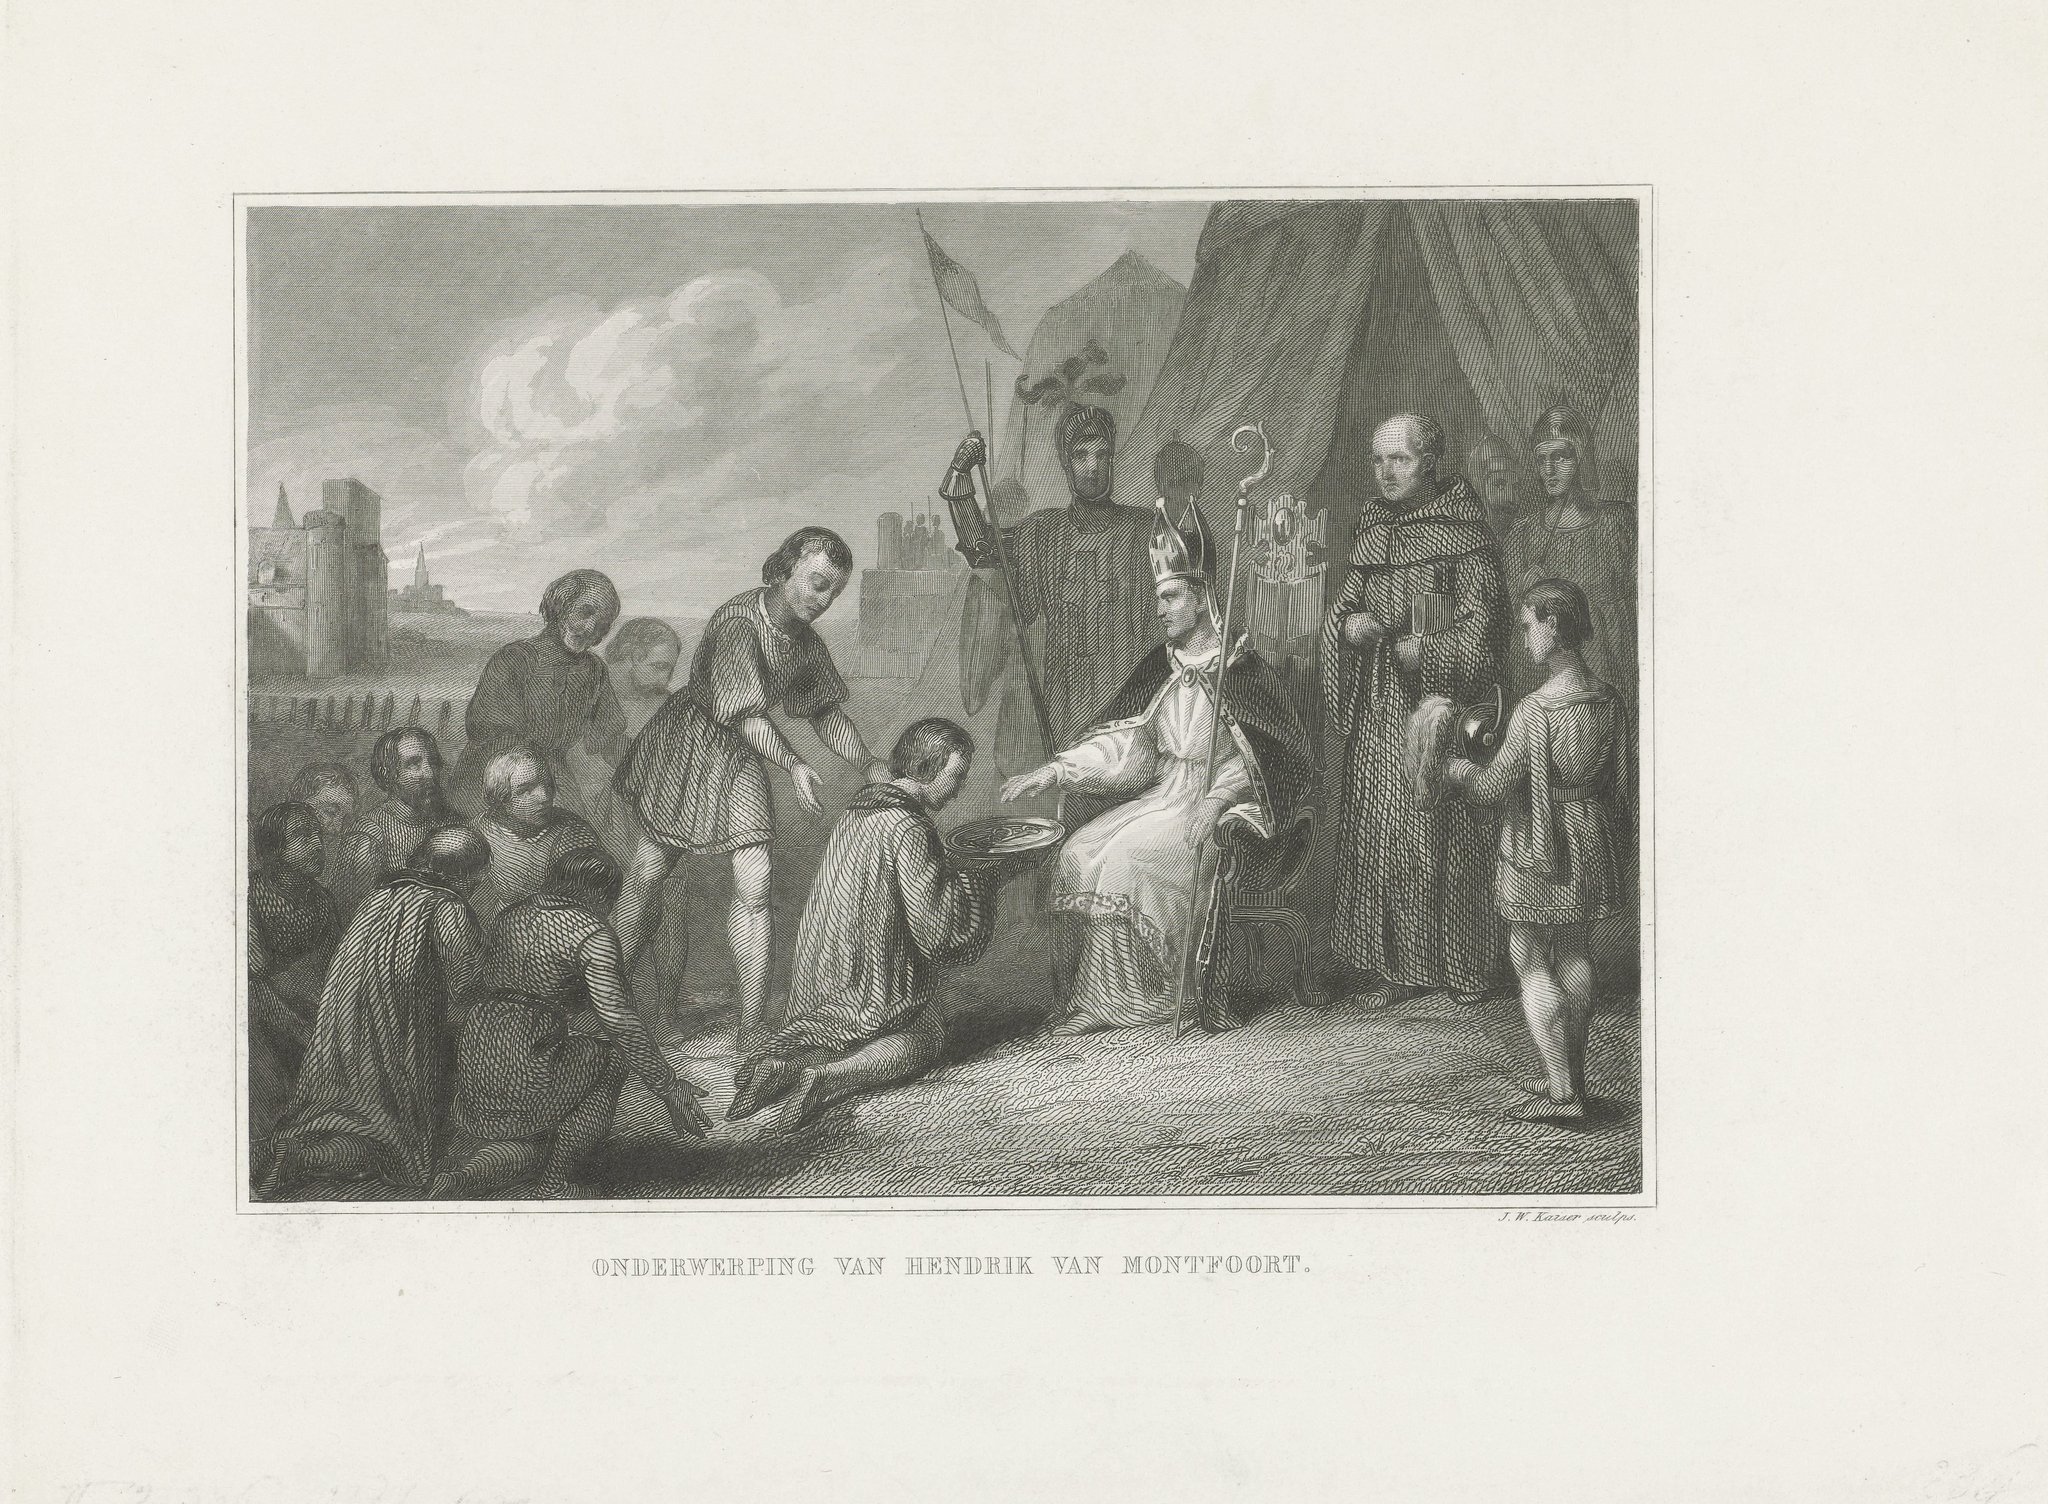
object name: book illustration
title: Onderwerping van Hendrik van Montfoort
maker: johann wilhelm kaiser (i)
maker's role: draughtsman, print maker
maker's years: 1813-1900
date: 1840-1884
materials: paper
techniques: engraving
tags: hendrik iii (burggraaf van montfoort), montfoort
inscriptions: collector's mark: Lugt 2228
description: De onderwerping van Hendrik van Montfoort aan de bisschop van Utrecht, 13 maart 1387. Hendrik zit op zijn knieën voor de bisschop van Utrecht en overhandigt hem op een bord de sleutels van de stad Montfoort. De geestelijke zit op een troon voor zijn tent, getooid met een mijter.